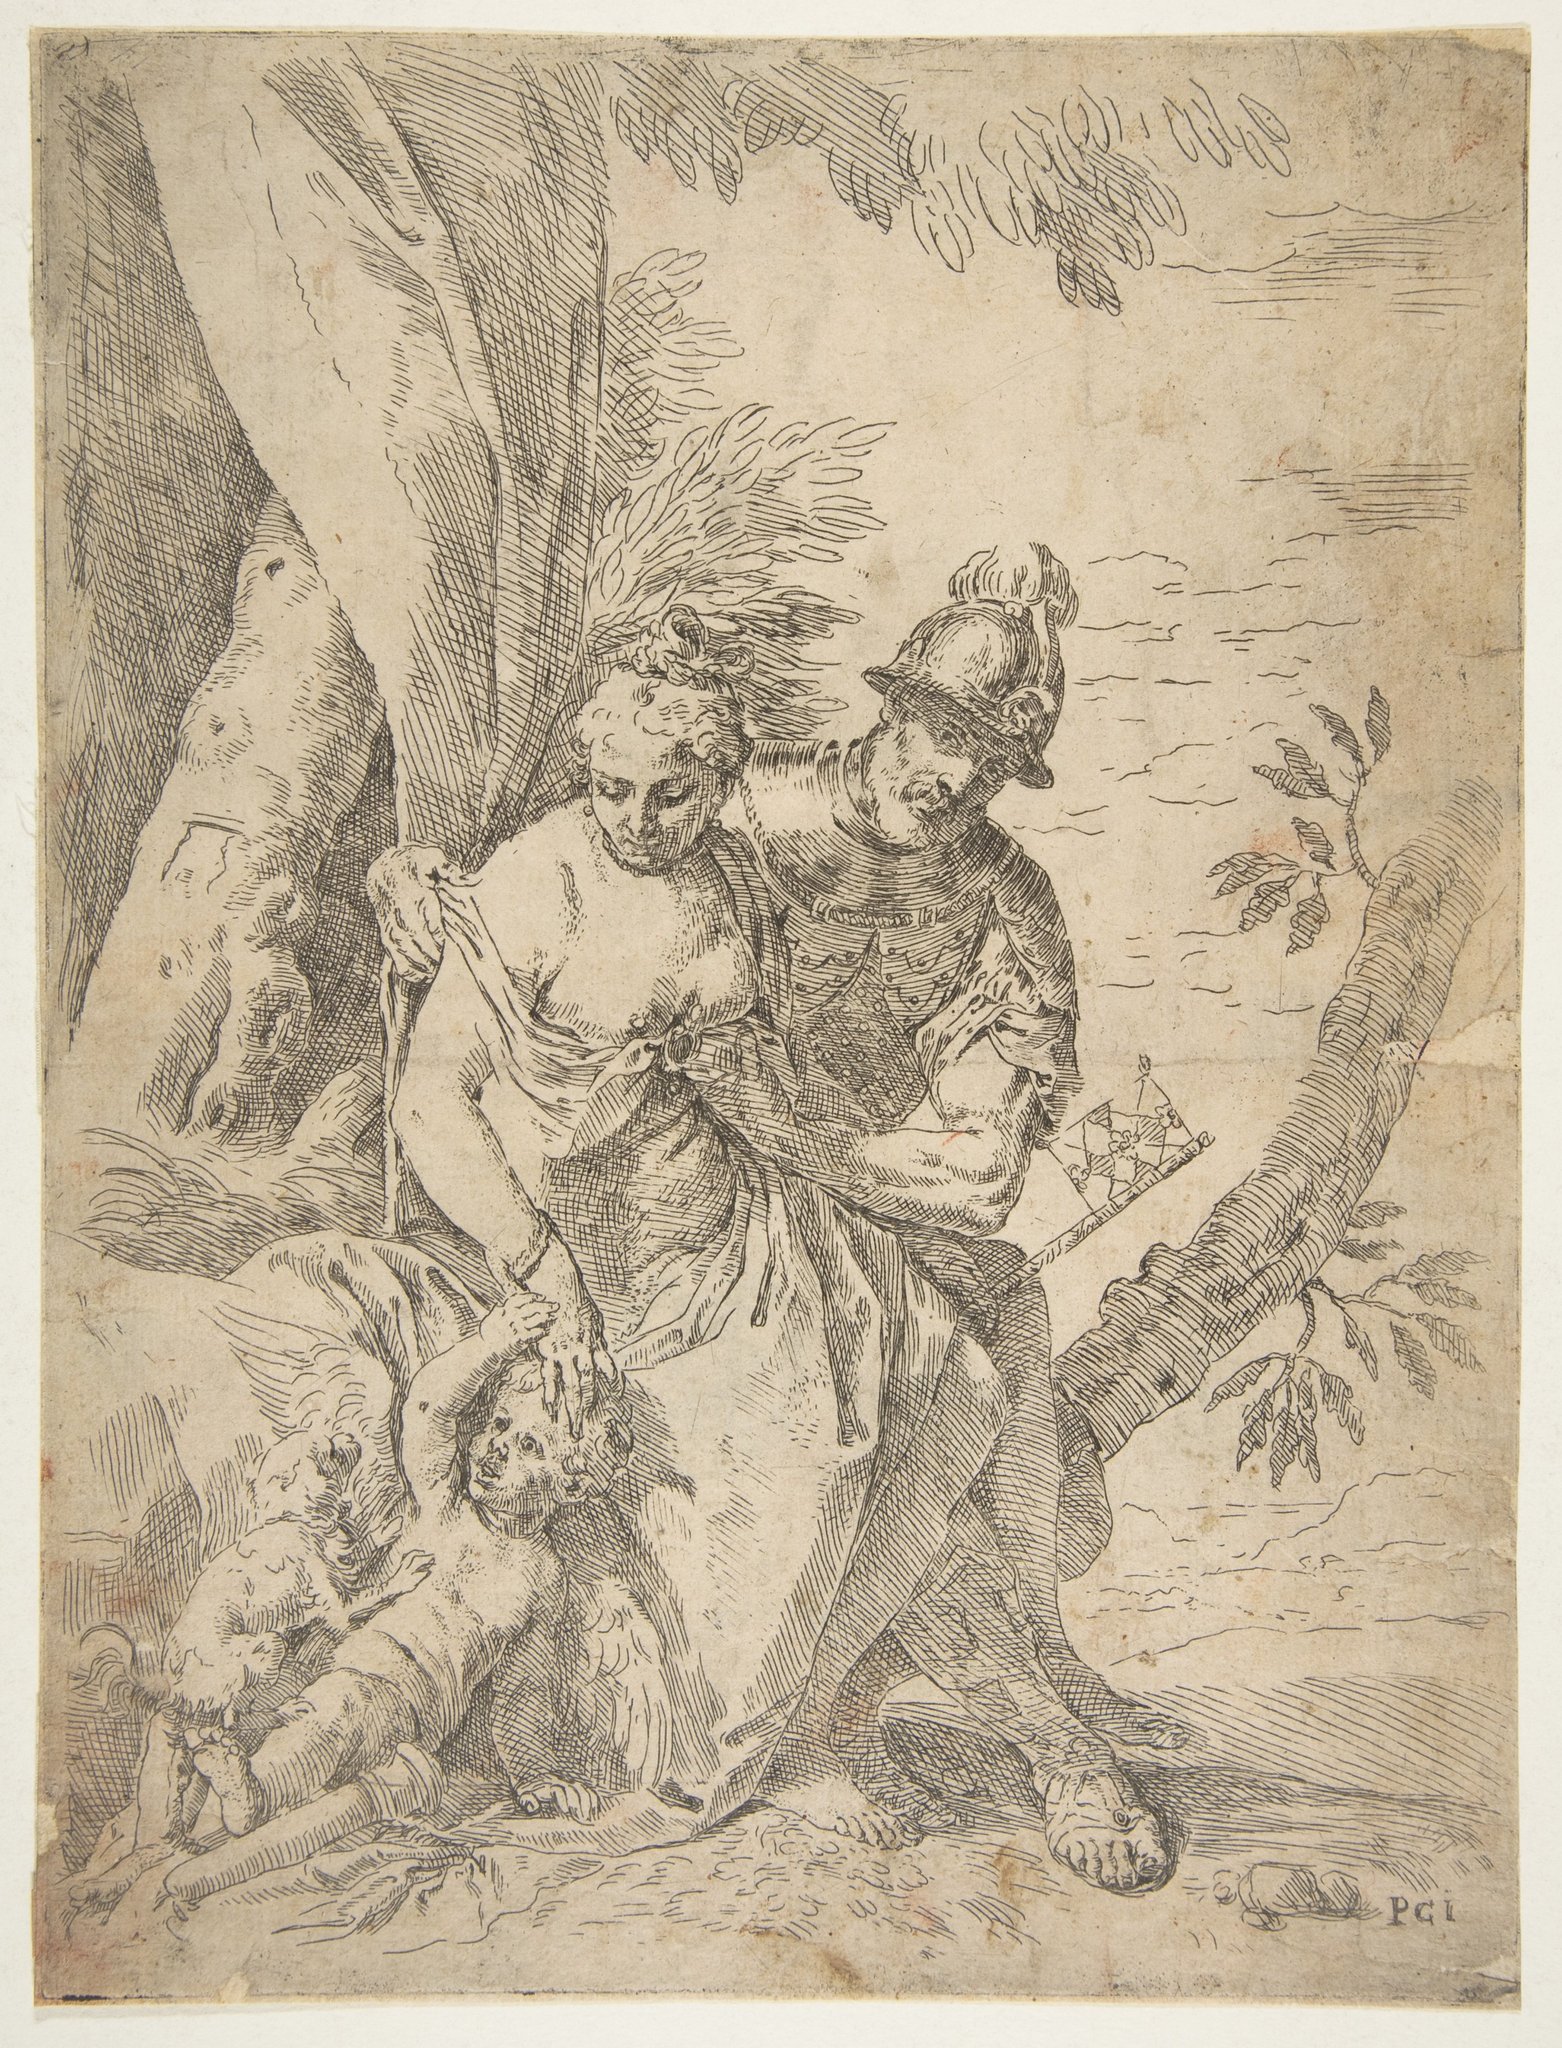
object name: print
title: Mars, Venus and Cupid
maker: simone cantarini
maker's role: artist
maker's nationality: italian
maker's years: 1612-1648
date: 1637-1639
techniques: etching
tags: cupid,mars,venus,trees